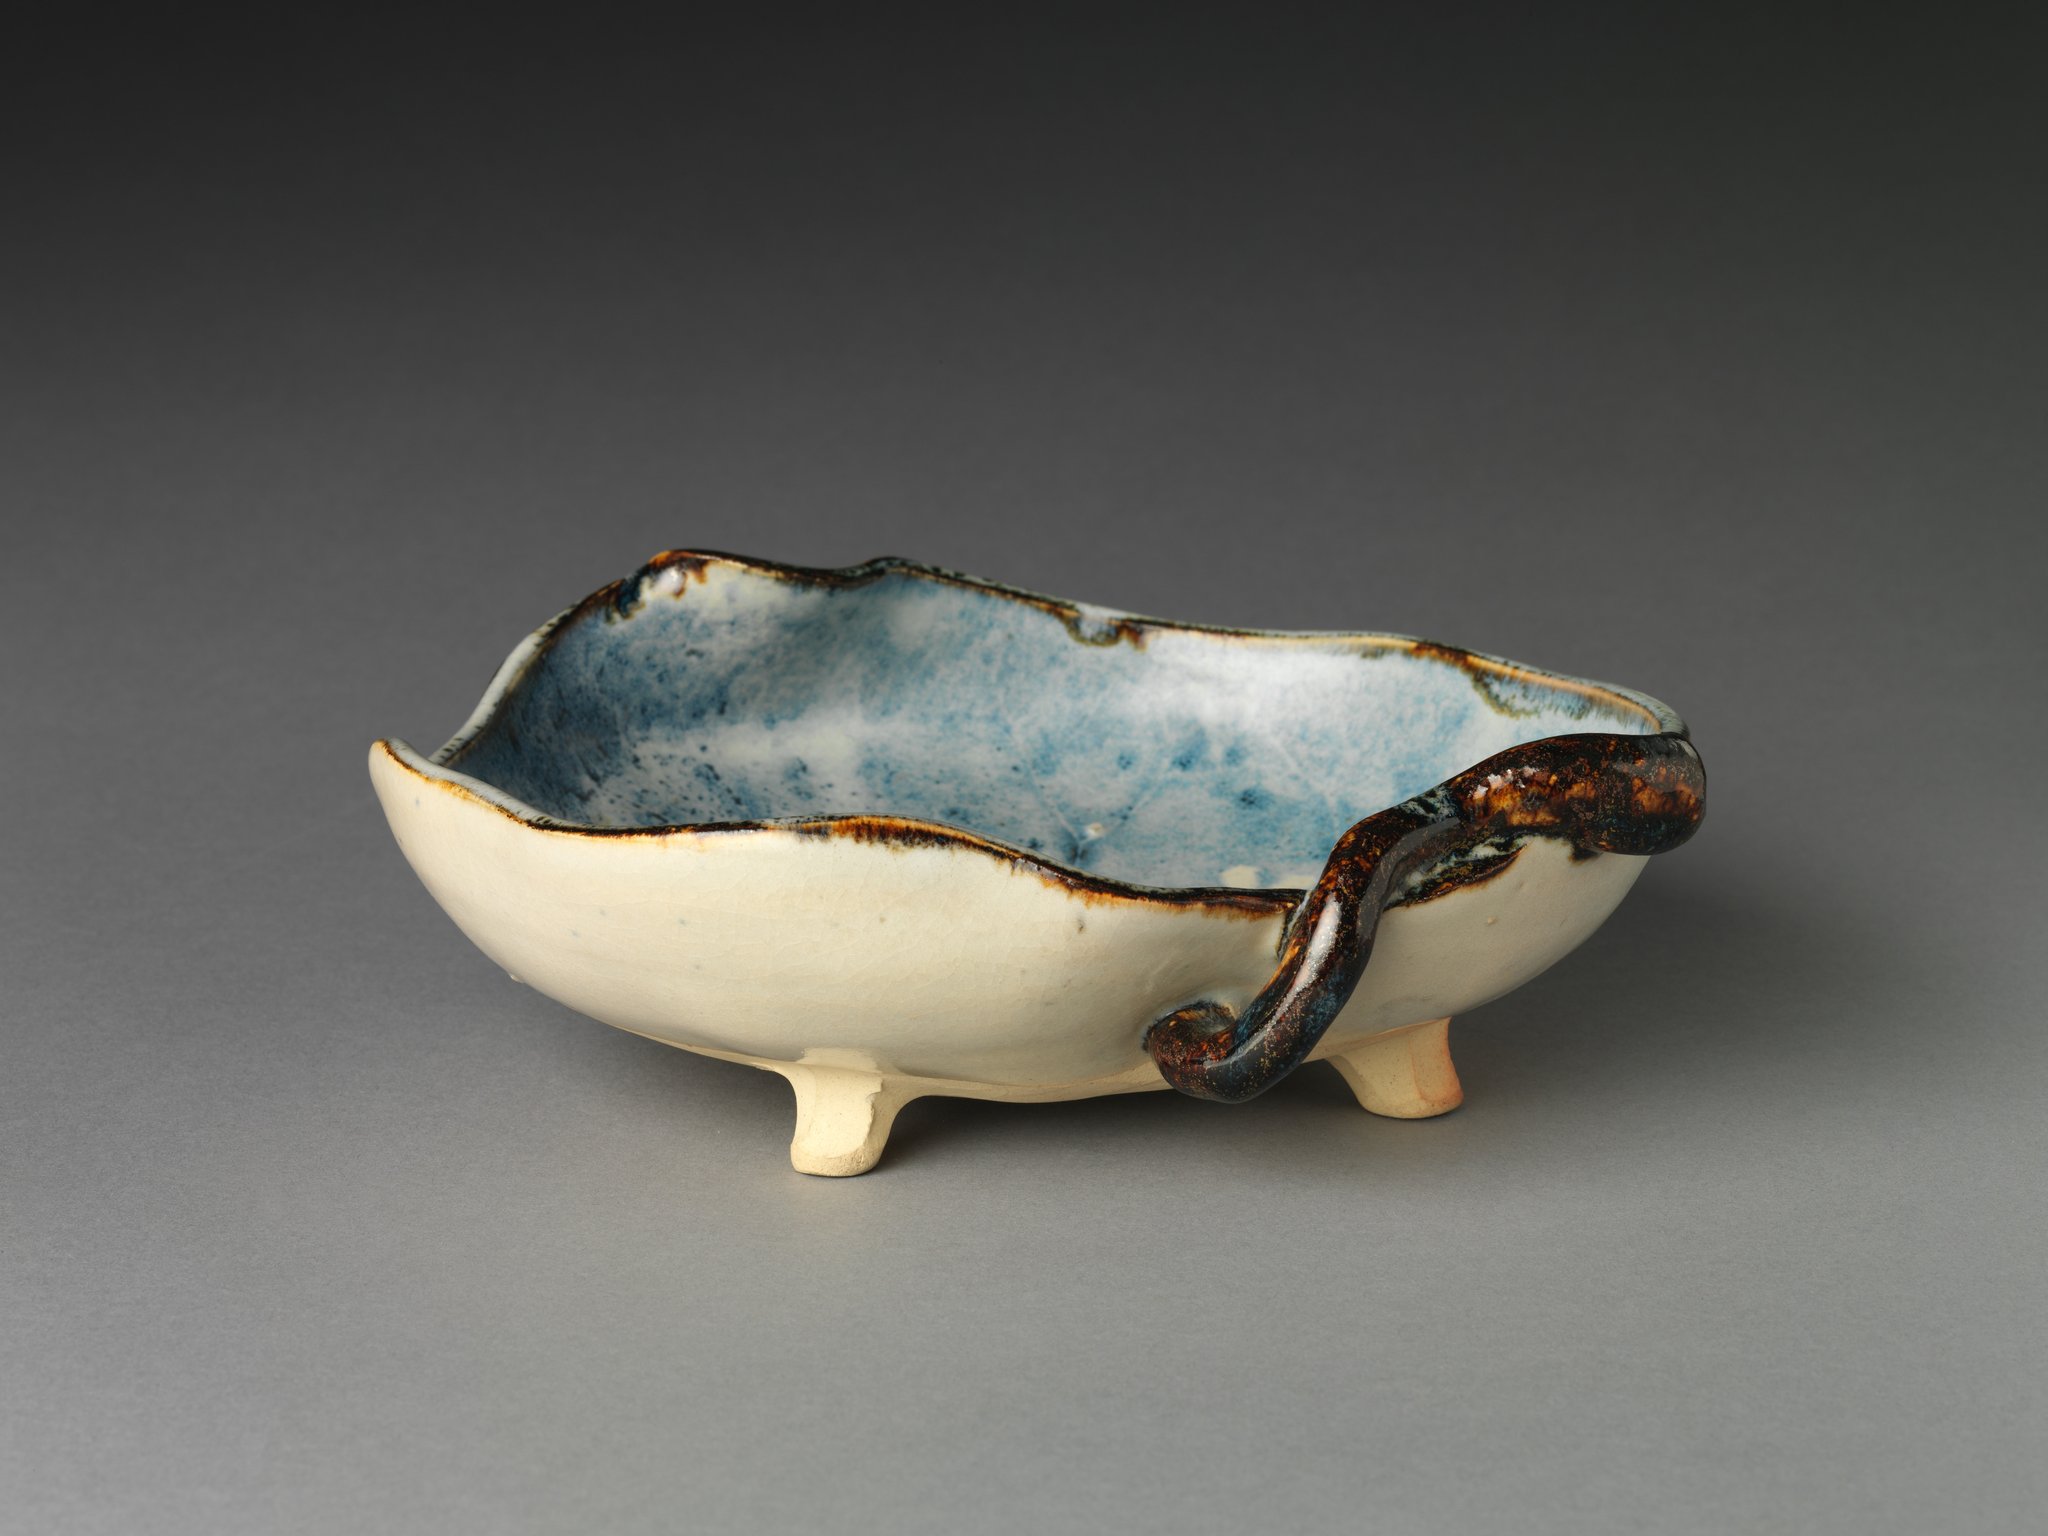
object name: bowl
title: Bowl in the Shape of a Paulownia Leaf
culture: japanese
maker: nin'ami dōhachi (takahashi dōhachi ii)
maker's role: artist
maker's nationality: japanese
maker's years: 1783-1855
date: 1851-1900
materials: glaze, stoneware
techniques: polychrome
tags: leaves